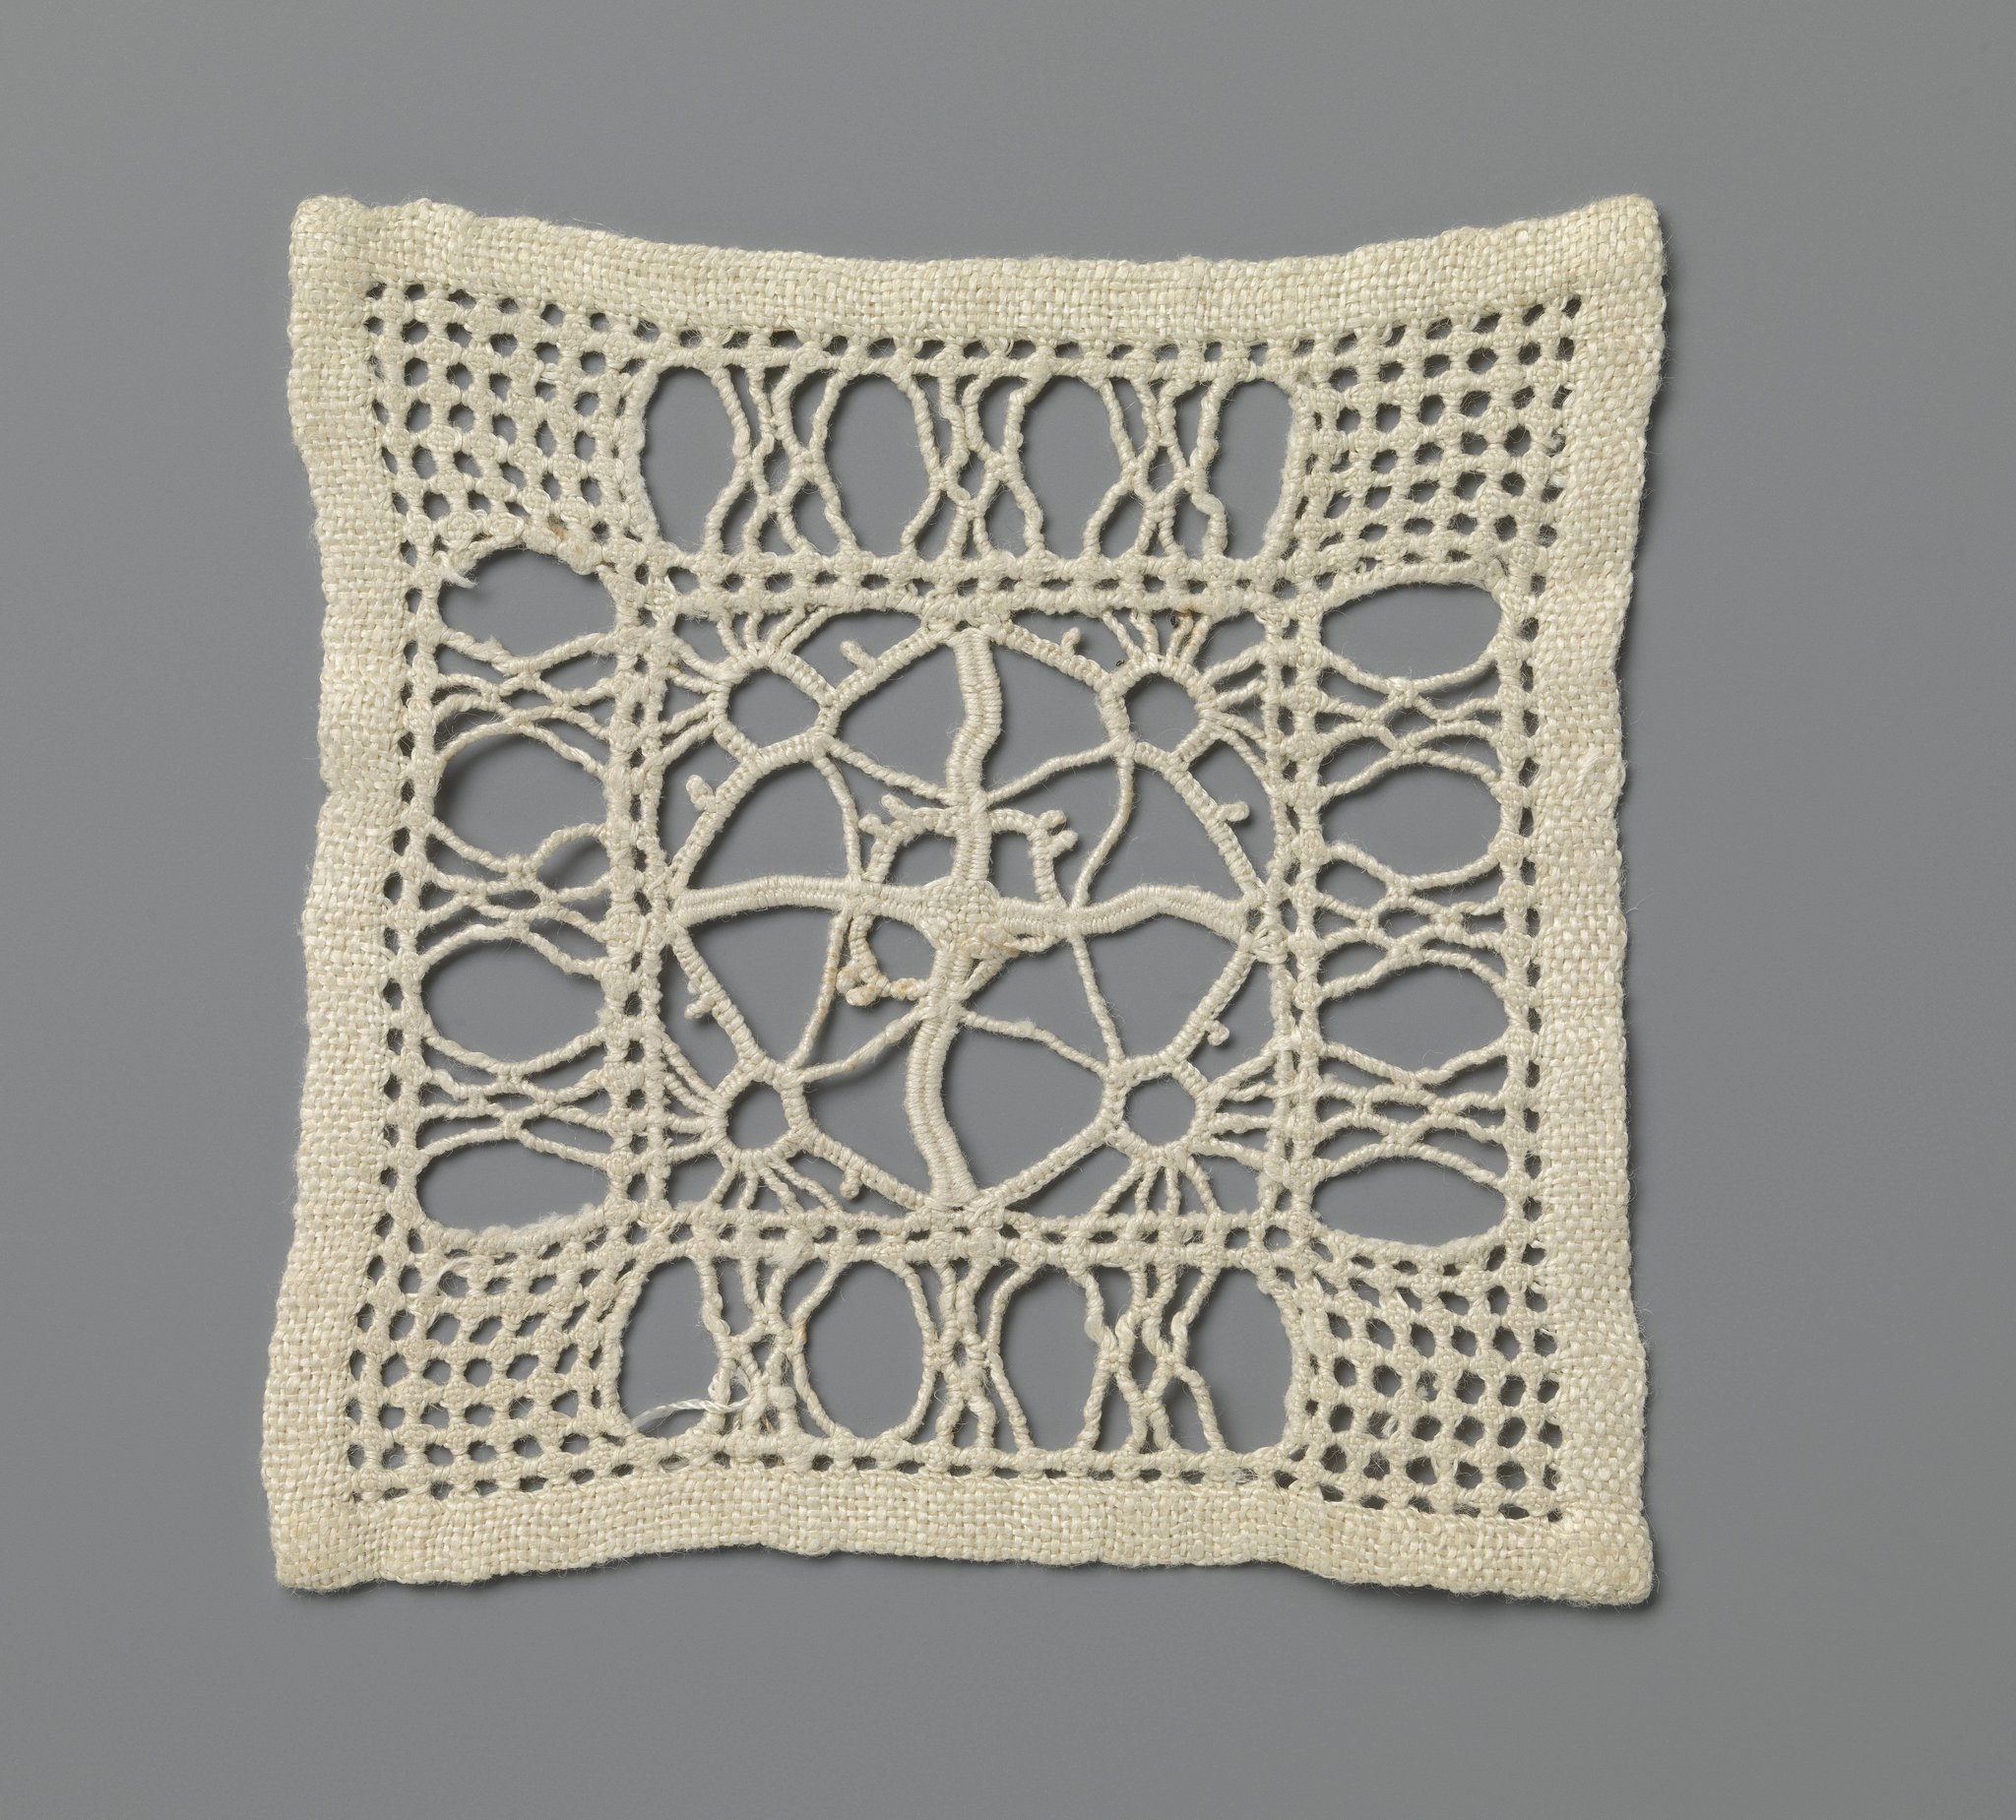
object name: mat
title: Kleedje van kantborduurwerk met opkomende zonnen langs ruitvorm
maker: Anonymous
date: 1900-1949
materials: cotton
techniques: lace embroidery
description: Vierkant kleedje van naturelkleurig kantborduurwerk, gesneden werk. Patroon met een vierkant die is opgebouwd uit vier kleine vierkanten. Elk klein vierkant is door een diagonale lijn verdeeld, met aan de buitenzijde een 'opkomende zon' en aan de binnenzijde een driehoek. Tezamen zorgt dit in het grote vierkant voor een ruitvorm met een vierpuntige ster in het midden. Om het grote vierkant aan alle zijden een rand met rechthoeken, gevuld met bundeltjes draden of met een dicht rasterwerk met opengewerkte ruitjes. Aan alle zijden een afgewerkte rand in linnenslag.